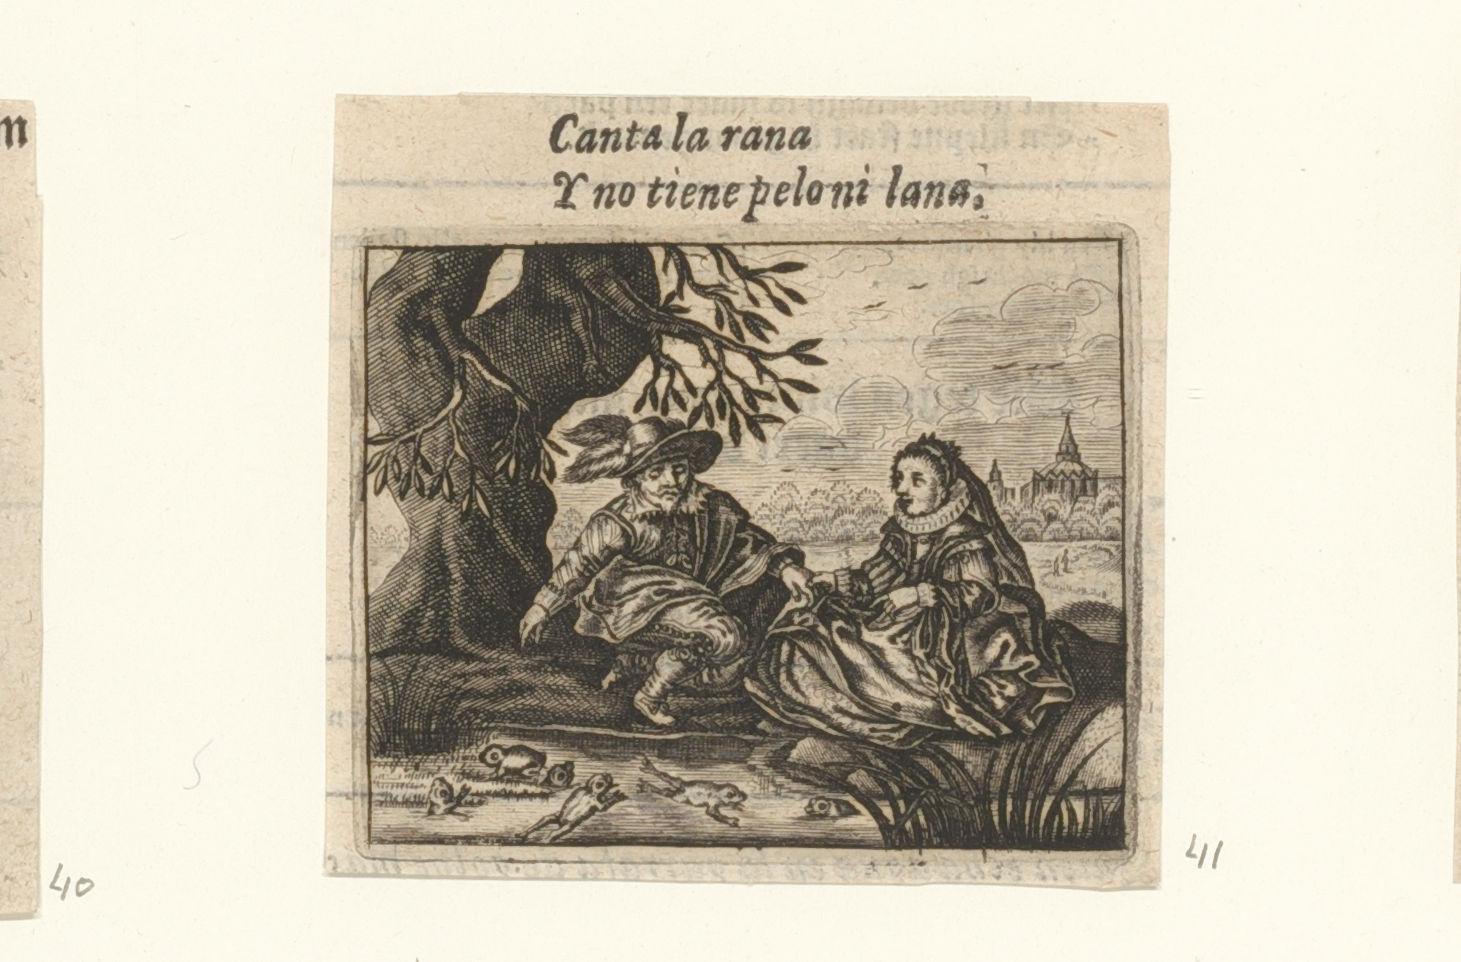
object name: print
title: Koppel kijkt naar wegspringende kikkers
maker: Anonymous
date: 1635-1715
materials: paper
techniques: engraving, letterpress printing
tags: tailless amphibians: frog, proverbs, sayings, etc., couple of lovers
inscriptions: collector's mark: Lugt 1641, stamp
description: Veel versies van dit embleem verschenen in verschillende uitgave van Spiegel van den Ouden ende Nieuwen Tydt. Zoals: Cats, Jacob. Spiegel van den Ouden ende Nieuwen-tijt, Bestaende uyt Spreeck-woorden (...). Dordrecht: Jacob Braat, 1647. Maar ook in andere publicaties (1665, 1671, 1715, 1722).